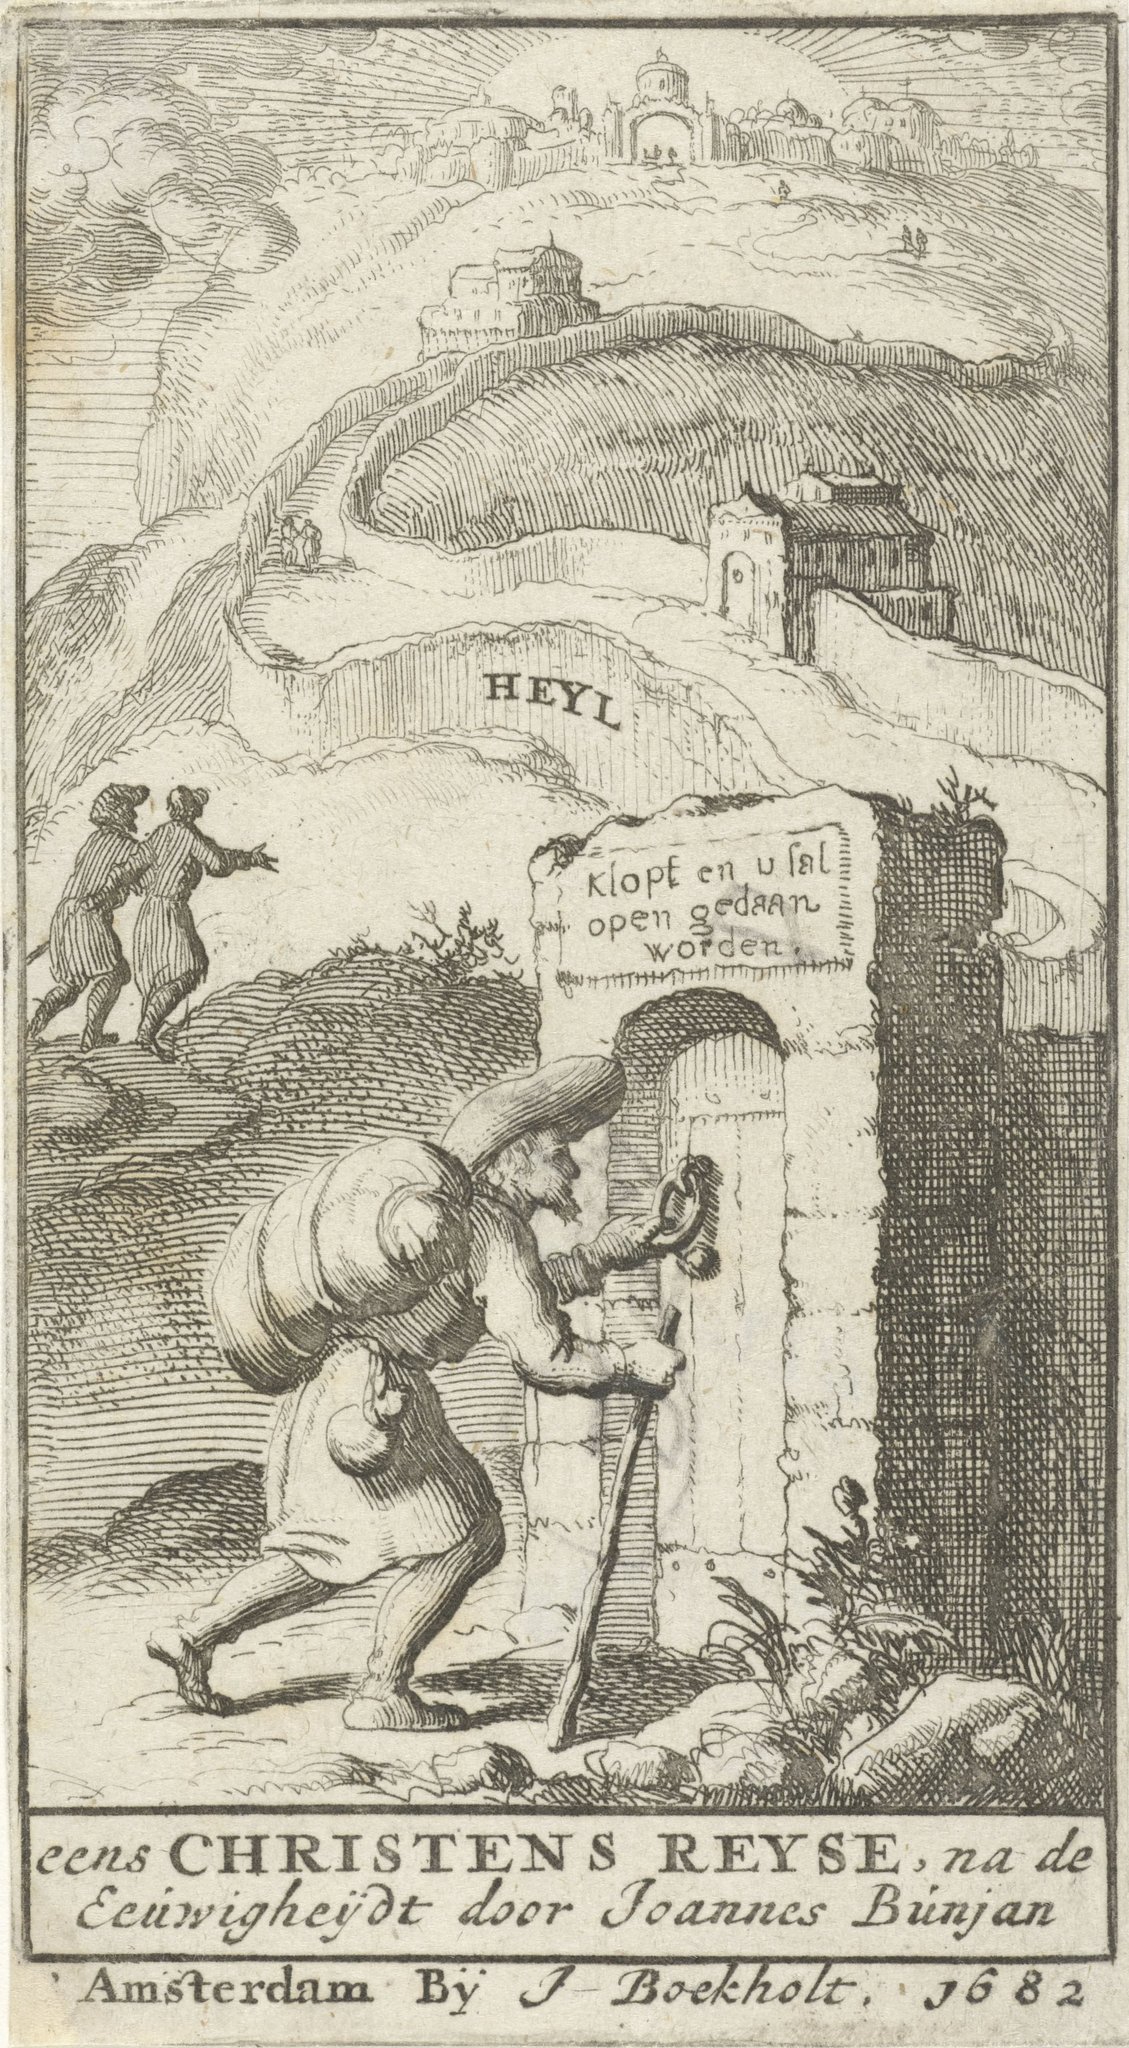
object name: titelblad, titelpagina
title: Pelgrim klopt aan bij een poort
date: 1682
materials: paper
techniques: etching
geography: amsterdam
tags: knocking at the door, pilgrimage, pilgrim(s) under way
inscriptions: collector's mark: Lugt 2228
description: Titelpagina voor: Bunyan, John. Eens christens reyse na de eeuwigheyt. Amsterdam: Johannes Boekholt, 1682.